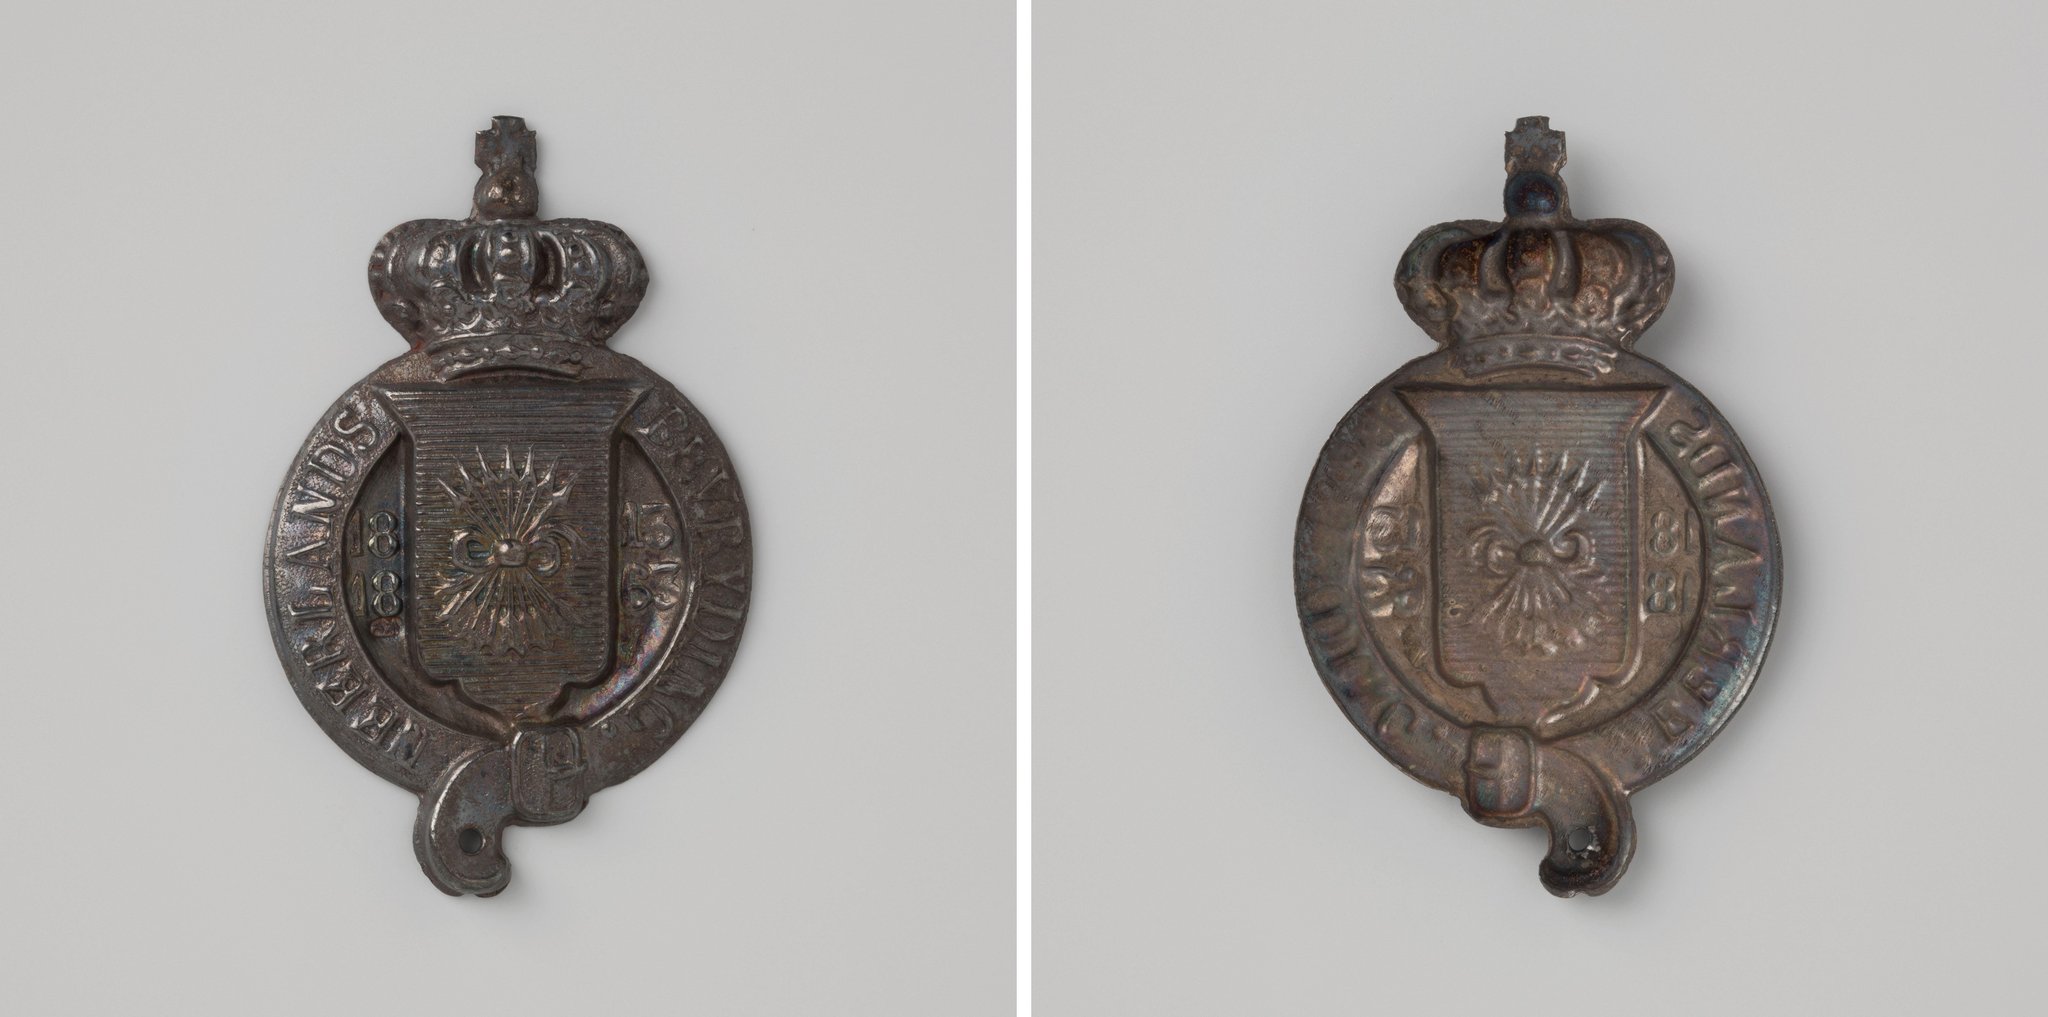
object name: insignia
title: Draagteken op de vijftigjarige herdenking van Nederlands onafhankelijkheid 1863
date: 1863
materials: silver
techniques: pressing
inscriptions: maker's mark, alloy mark: ‘zwaard’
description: Zilveren applique met gekroond wapenschild met pijlenbundel, tussen de cijfers 18 - 13 en 18 - 63, omringd door een beschreven riem met gesp. Ingeslagen gehalte- en meesterteken.